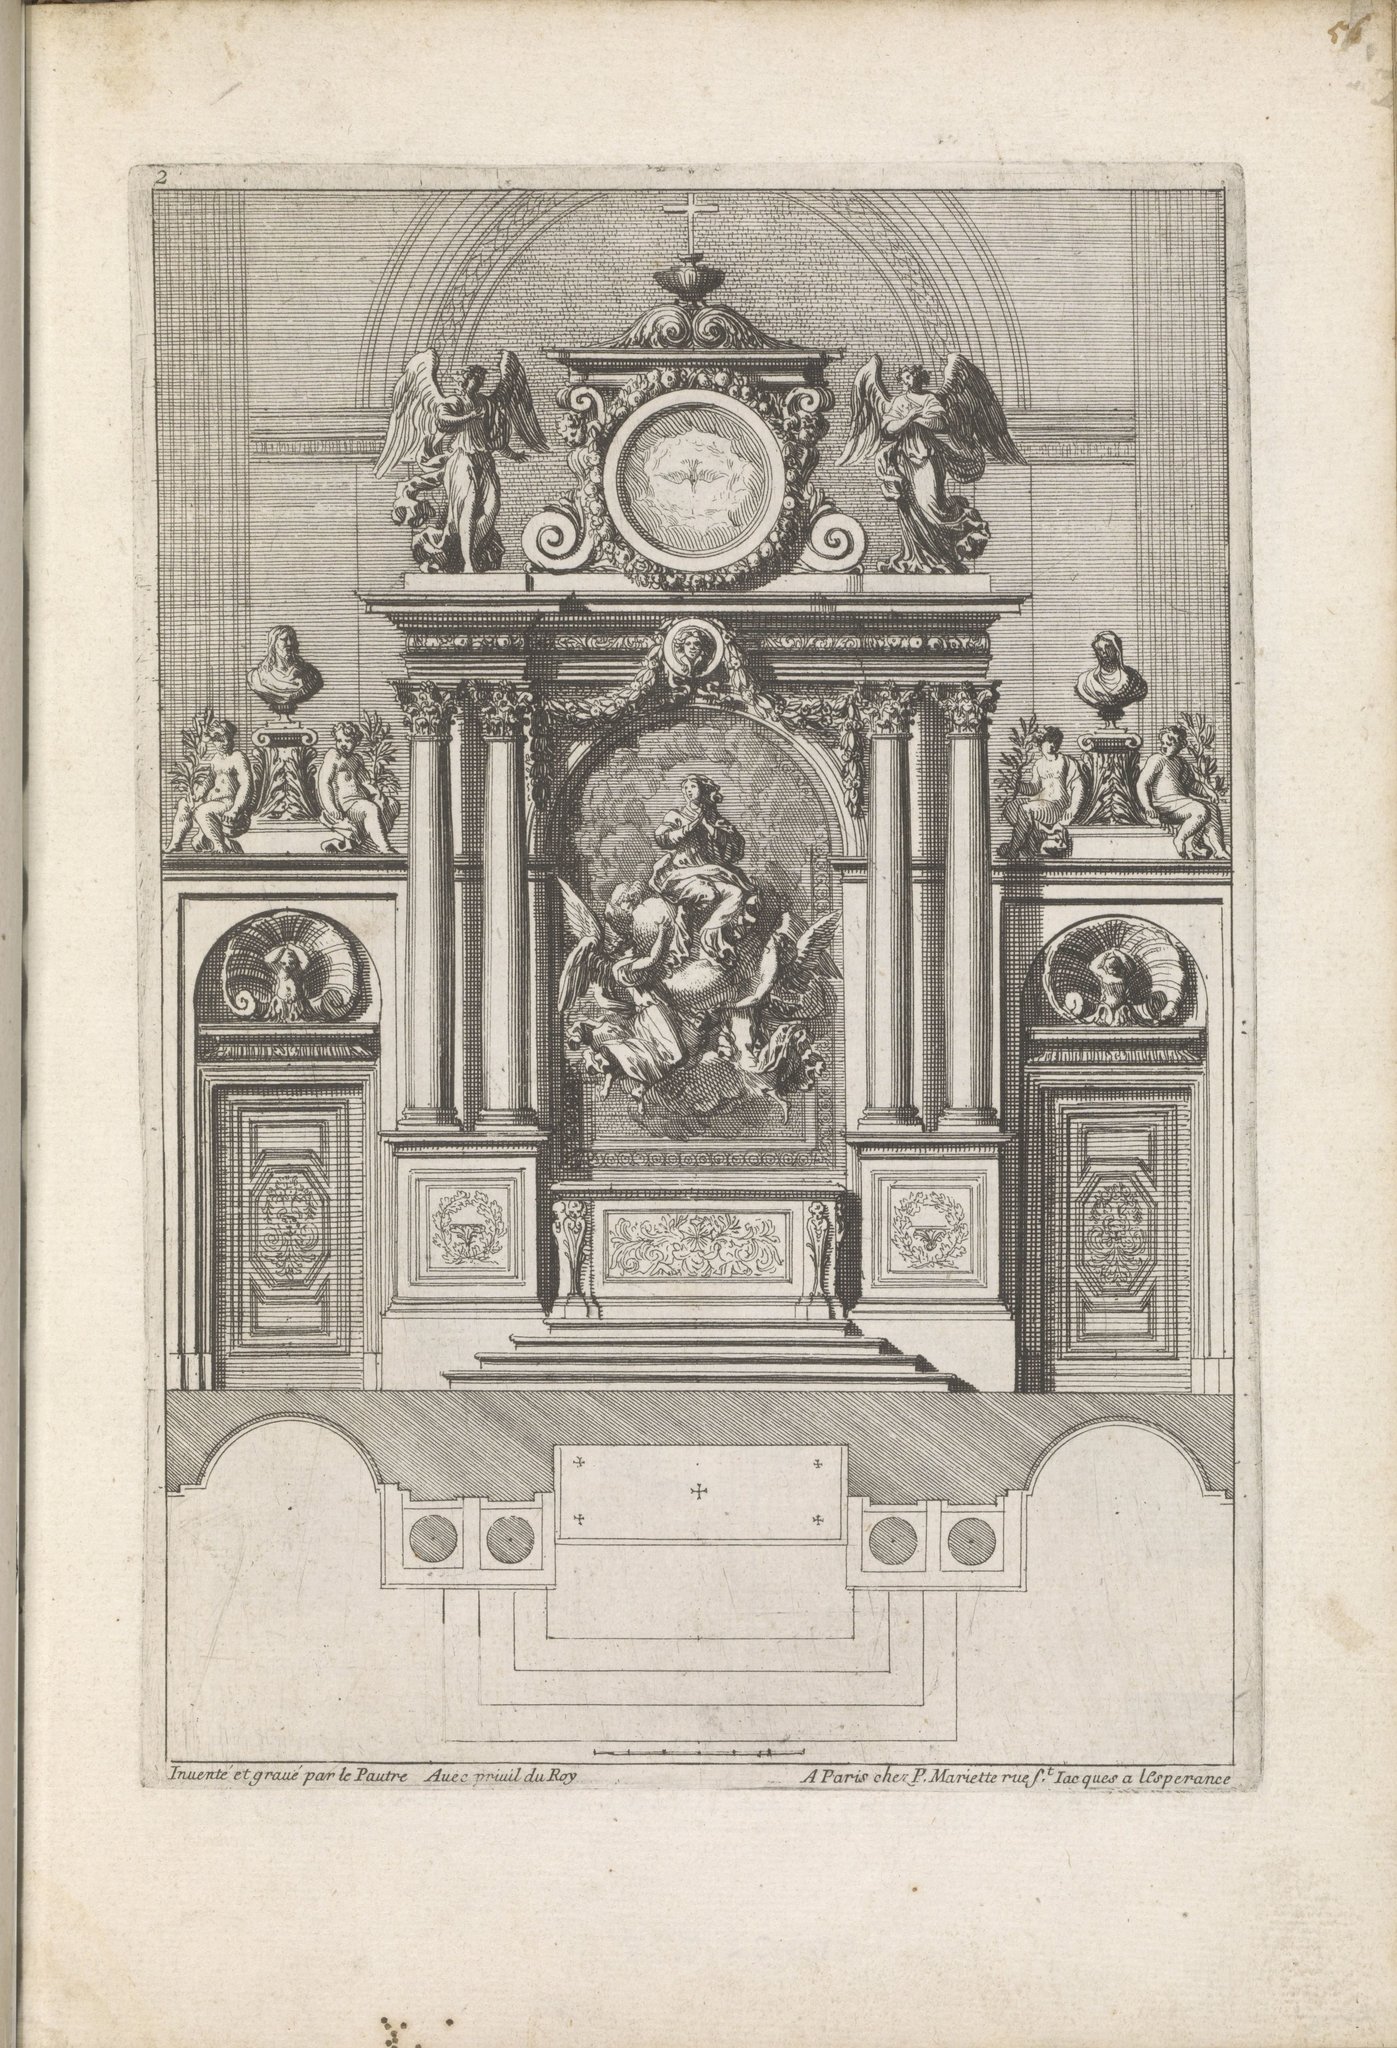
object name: album leaf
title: Altaar met een schilderij van de Hemelvaart van Maria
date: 1658-1670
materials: paper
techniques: etching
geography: paris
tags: the assumption of mary ('assumptio corporis'): she is borne into heaven by angels, altar with altar-piece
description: Altaar met een schilderij van de Hemelvaart van Maria tussen twee dubbele Korinthische zuilen. Bovenaan een medaillon met de duif van de Heilige Geest. Onderaan de plattegrond van het altaar. Prent maakt deel uit van een album.